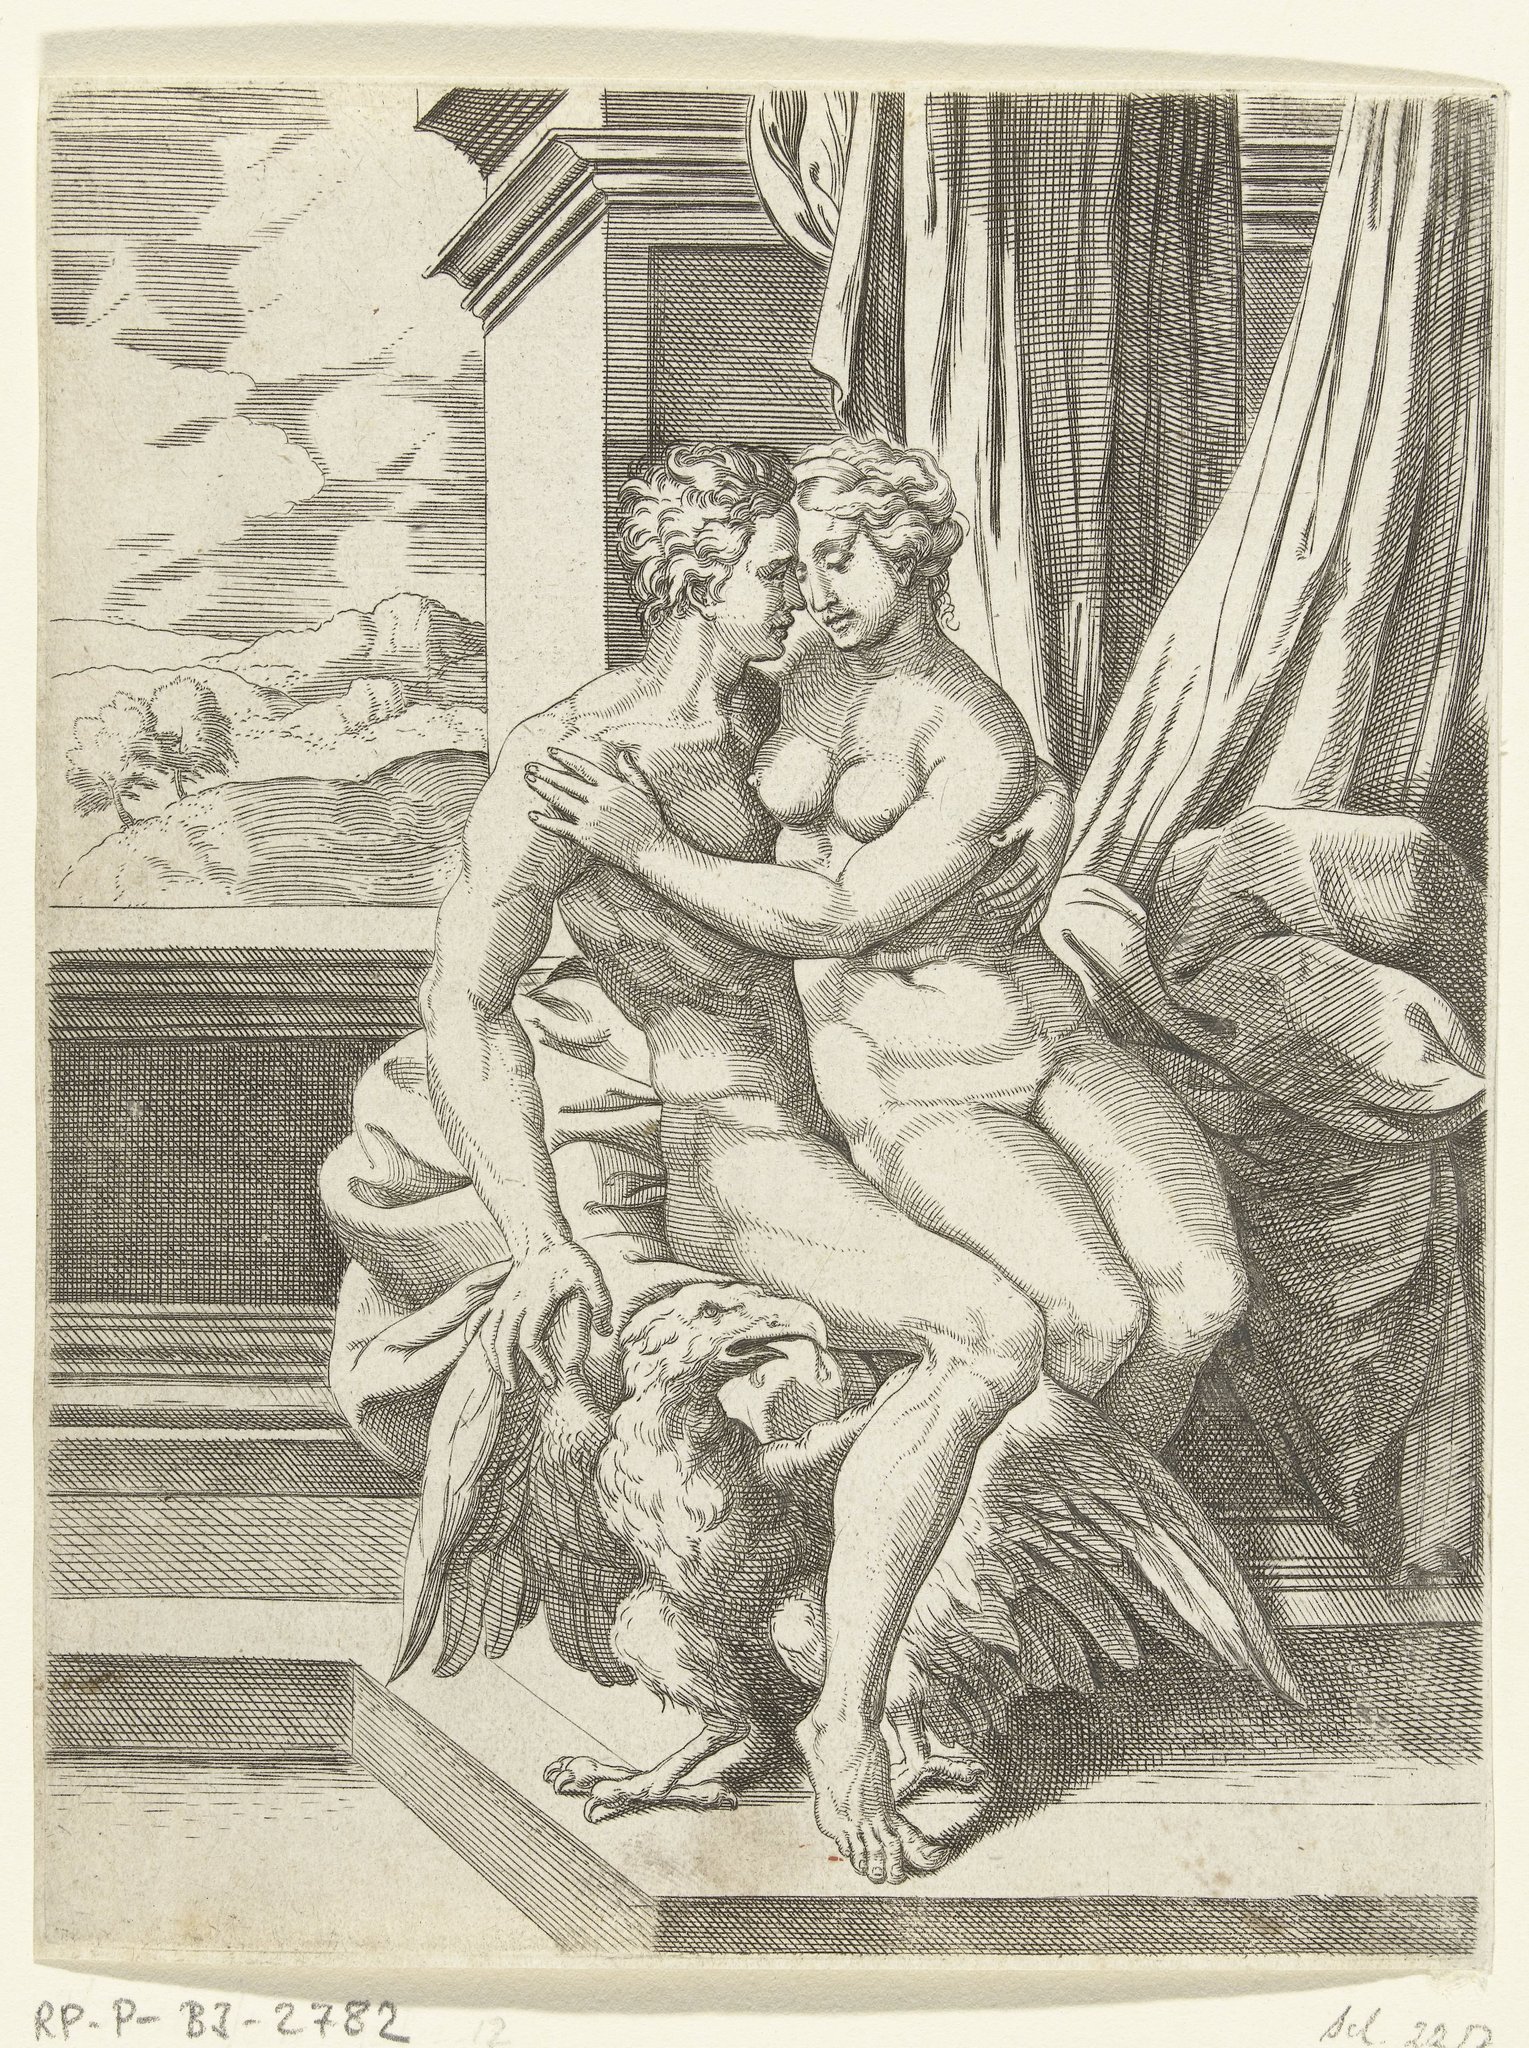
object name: print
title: Jupiter en Alcmene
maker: cornelis bos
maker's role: print maker, printer, publisher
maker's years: 1510-1566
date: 1537-1555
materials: paper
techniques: engraving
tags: jupiter, in the guise of amphitryon, and alcmene, mother of hercules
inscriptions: collector's mark: Lugt 240, collector's mark: Lugt 2228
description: Jupiter verleidt Alcmene in de gedaante van haar man Amphitryon. Alcmene raakt zwanger en baart later Hercules. Jupiters adelaar zit naast Jupiter en Alcmene op de grond. Prent uit een serie van 10 prenten die het liefdesleven van Jupiter illustreren.